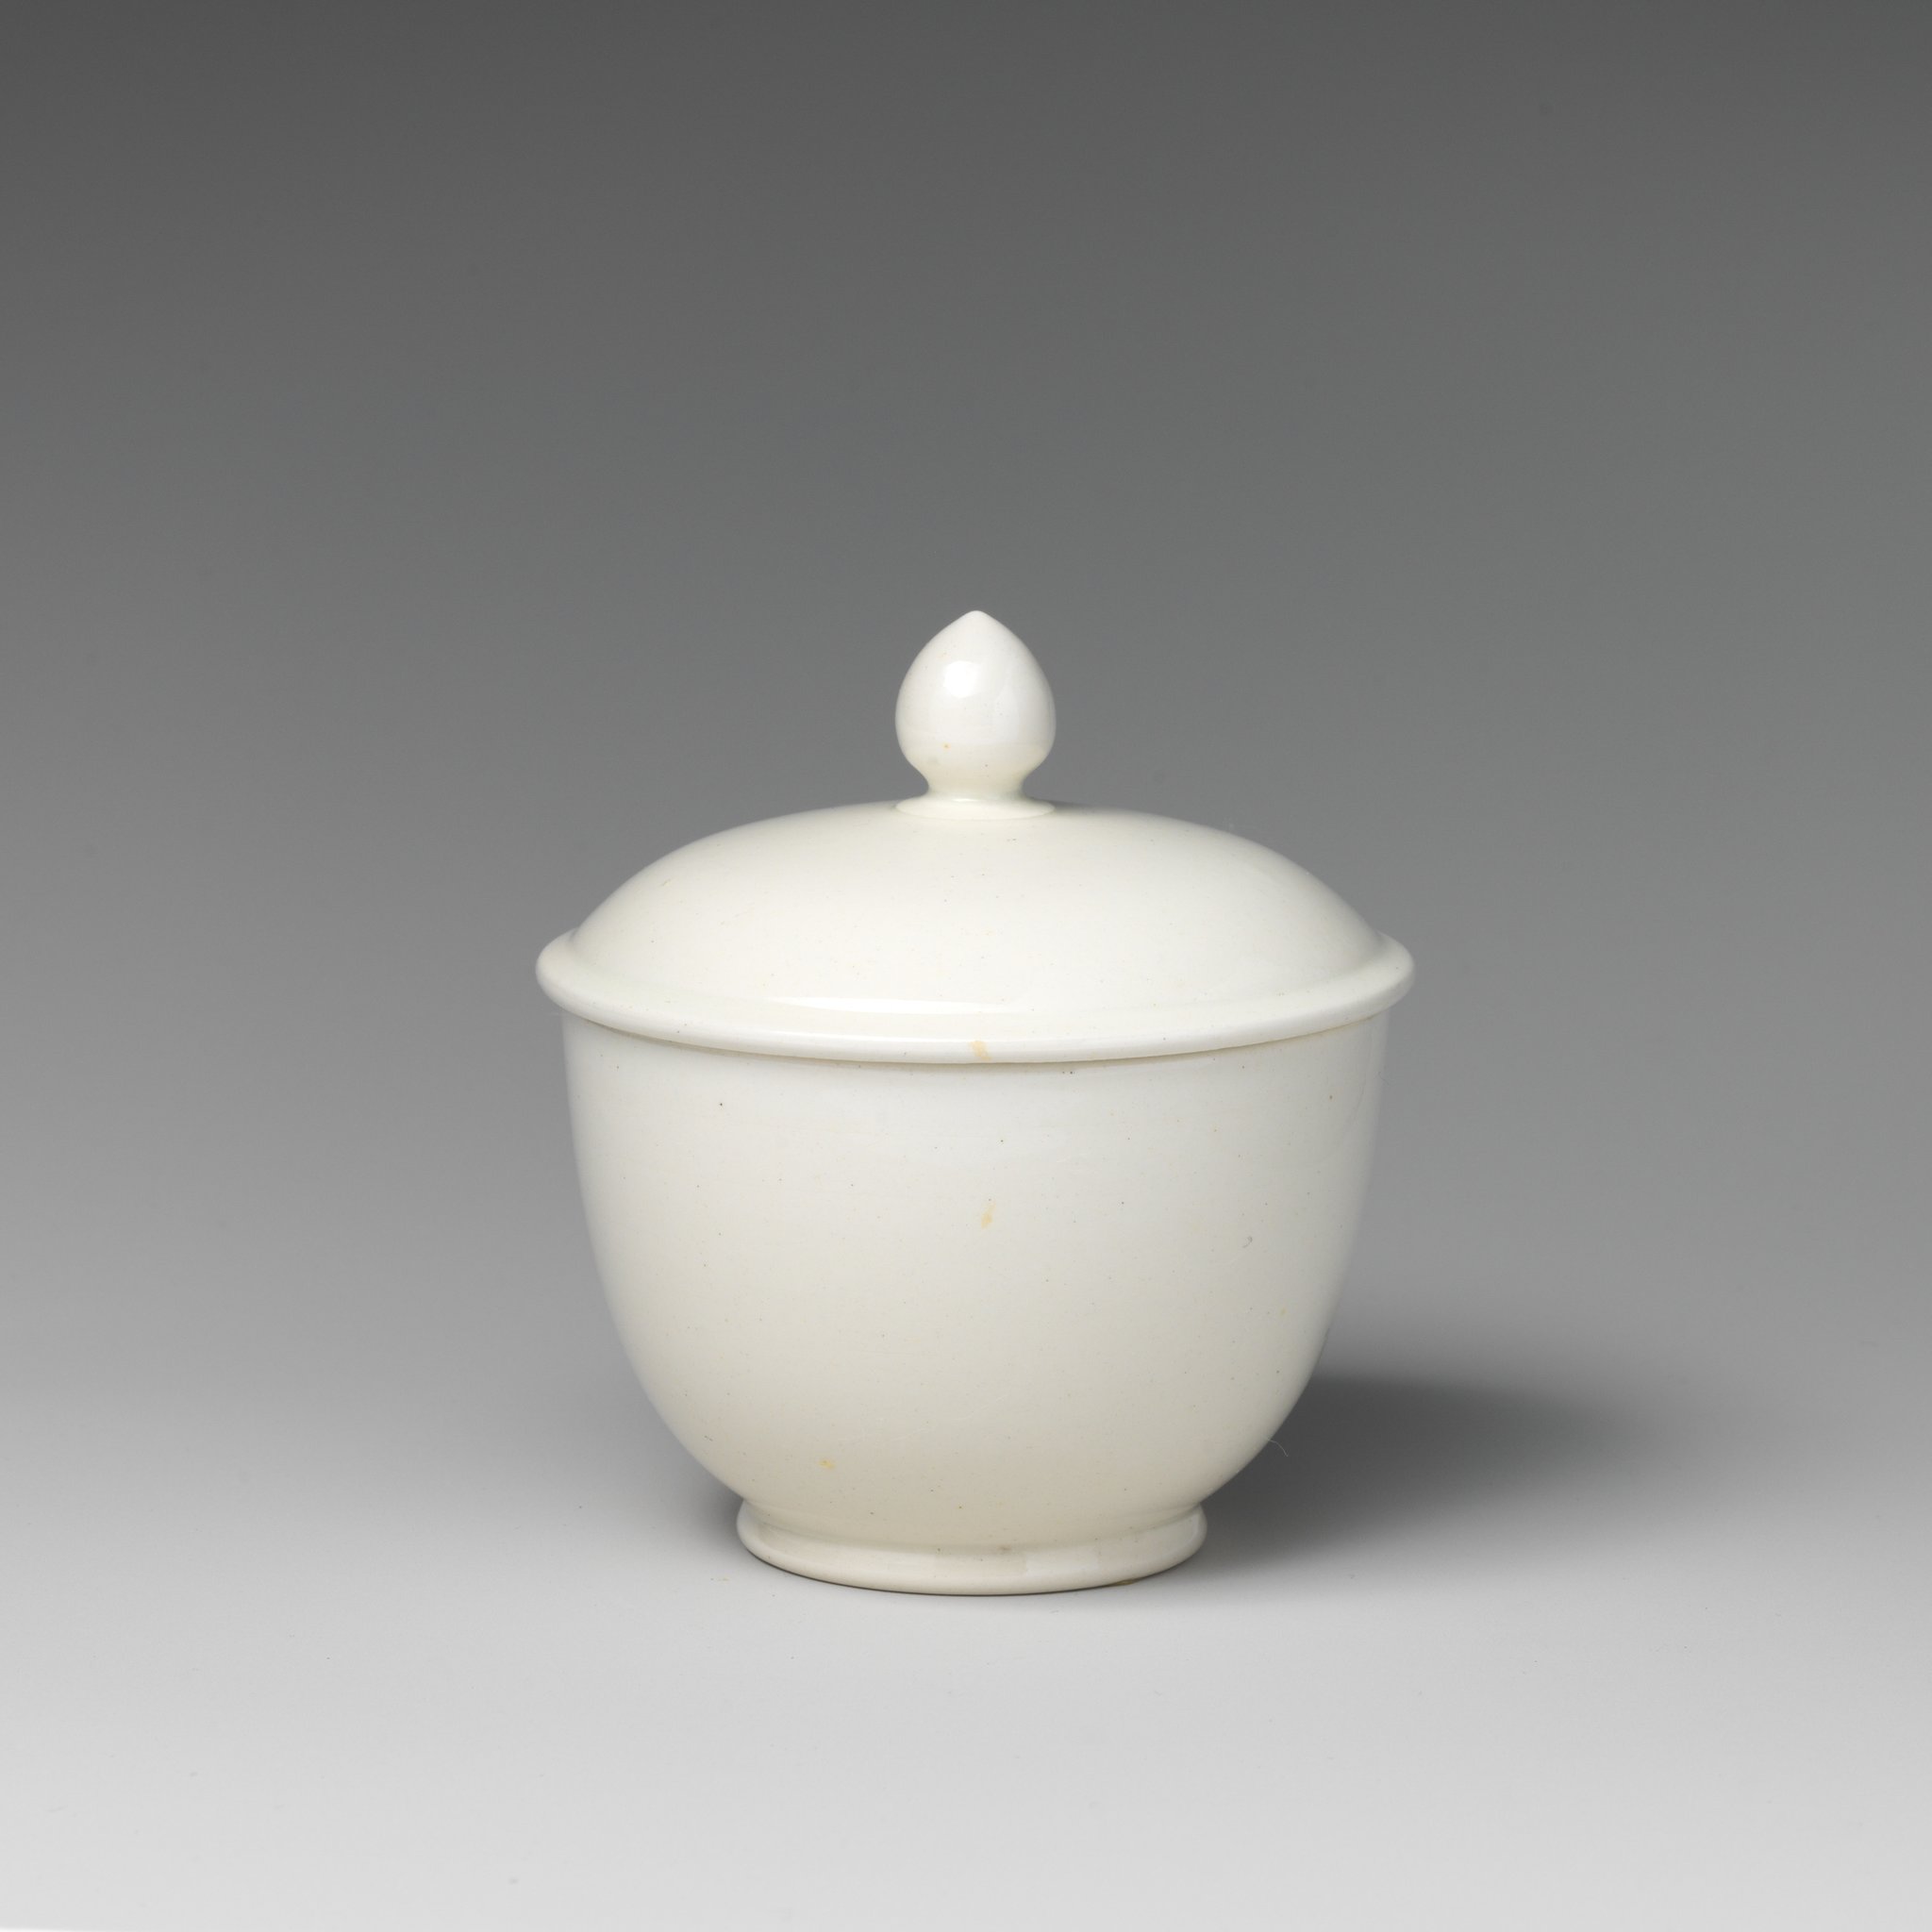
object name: miniature sugar bowl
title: Miniature sugar bowl with cover (part of a set)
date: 1800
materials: soft paste porcelain